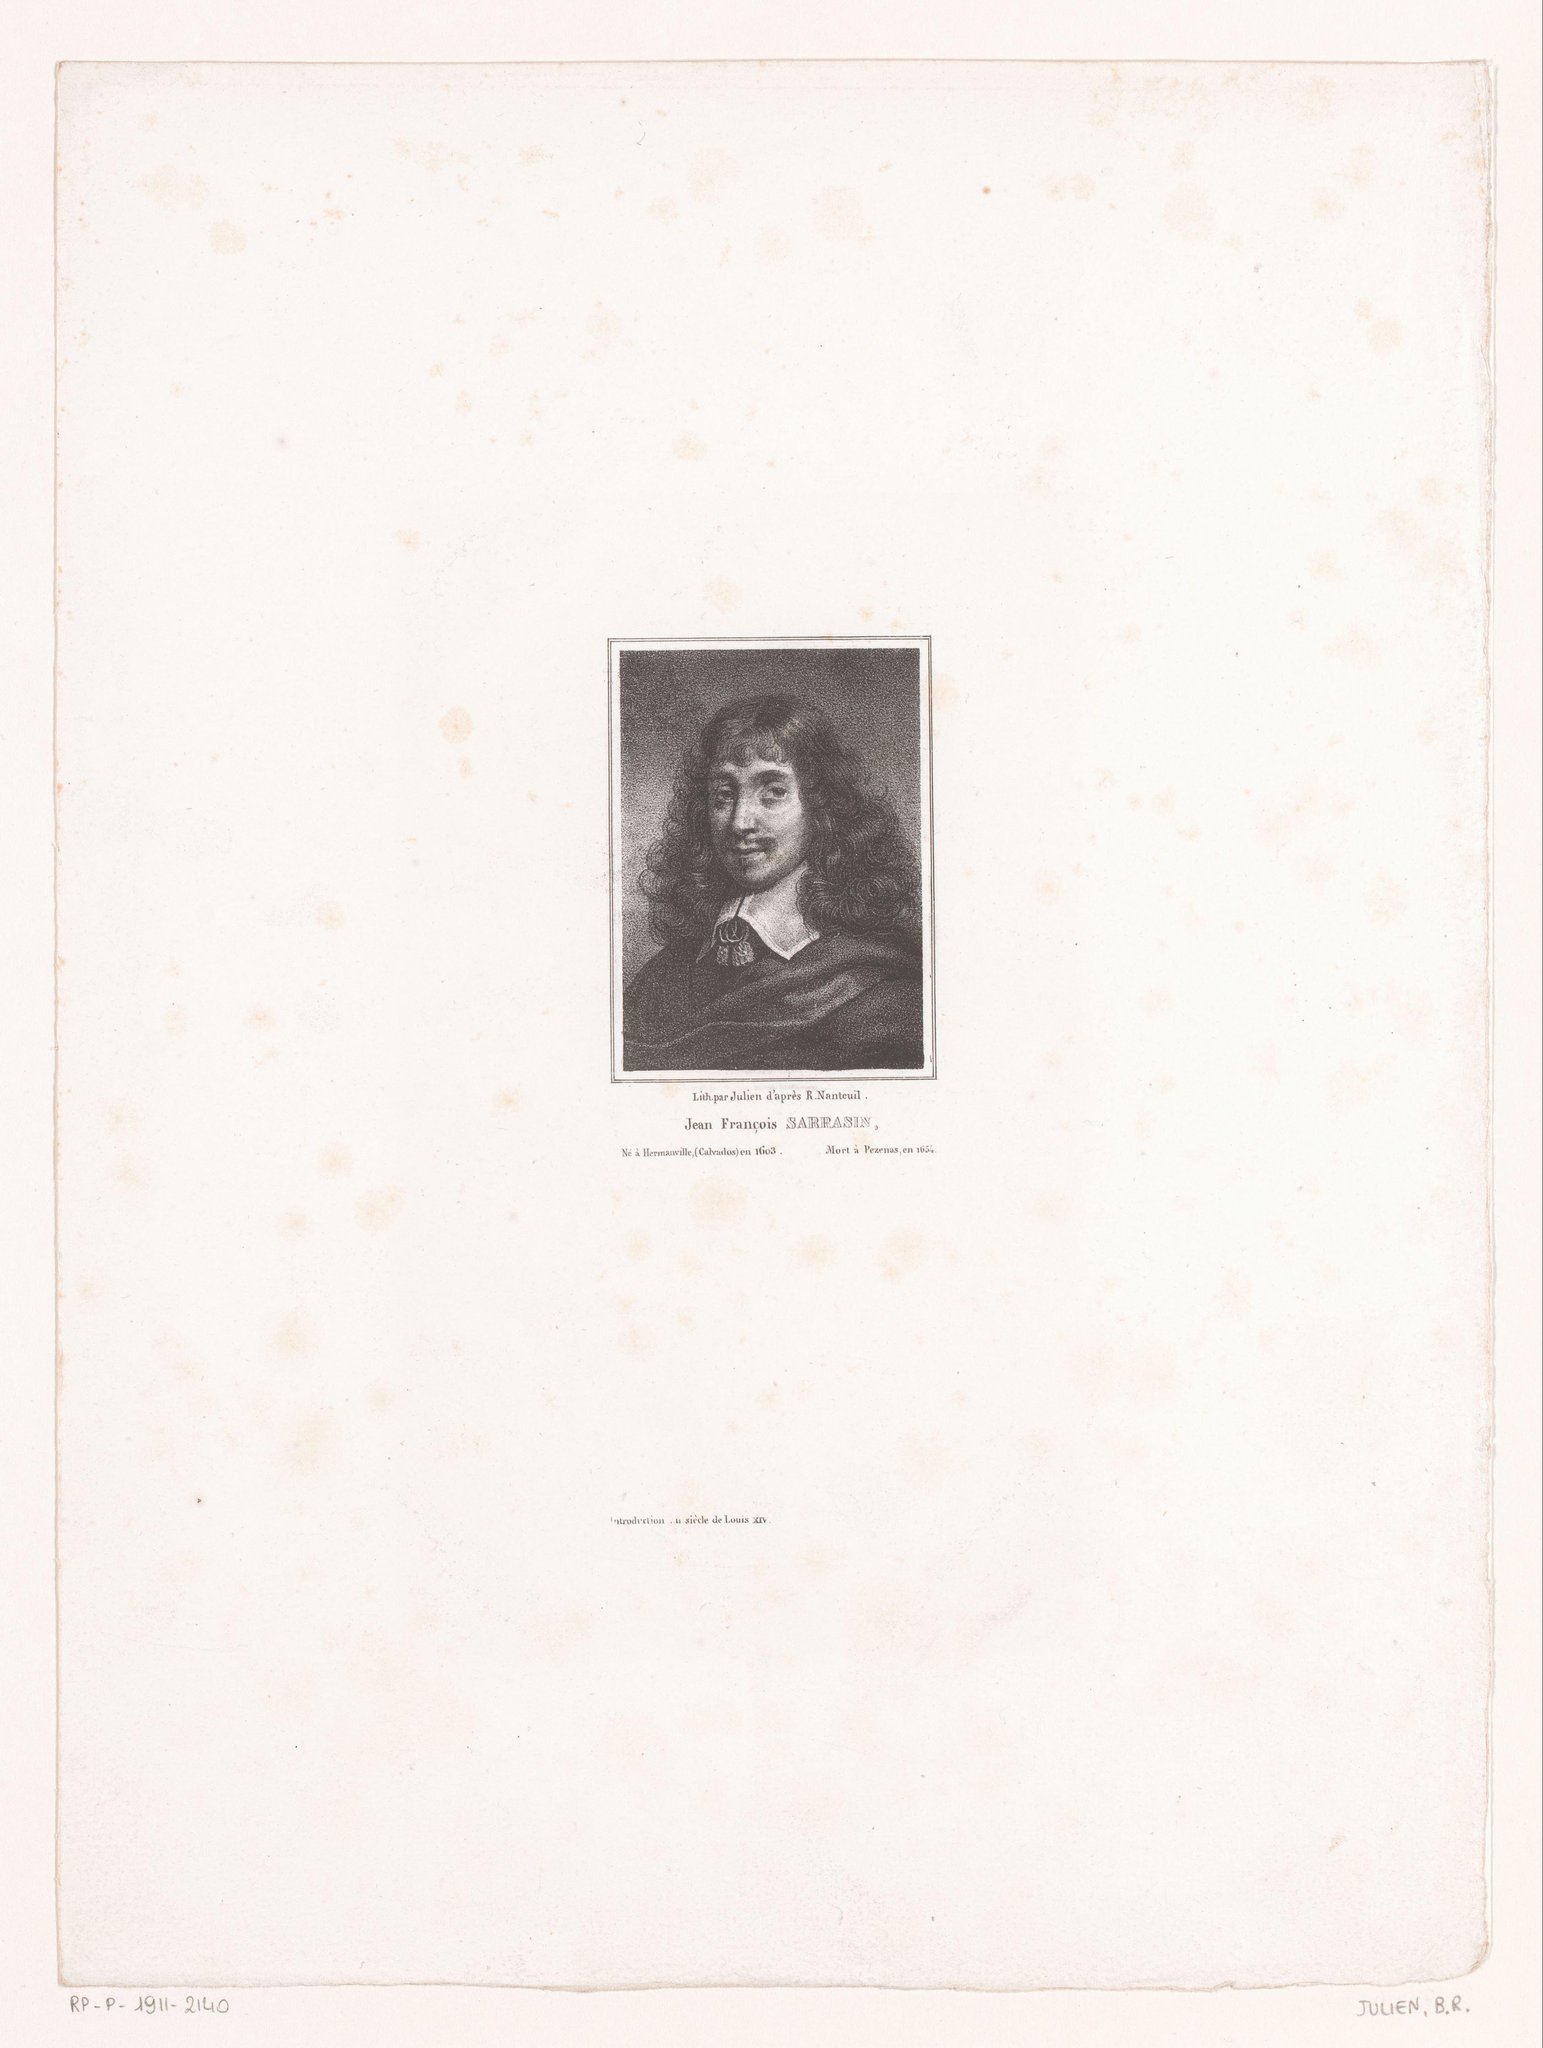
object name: print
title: Jean François Sarrasin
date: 1830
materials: paper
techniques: lithograph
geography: paris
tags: historical persons, portrait of a writer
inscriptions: collector's mark: Lugt 2228a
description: Prent gebruikt voor: Illustrations du Cours de Littérature de la Harpe, ou collection de 400 portraits destinés à l'ornement de cet ouvrage. Parijs: Boblet, 1830.